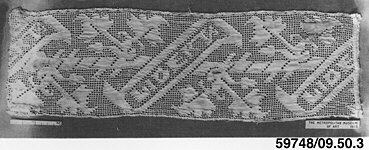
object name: strip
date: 1501-1700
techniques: embroidery